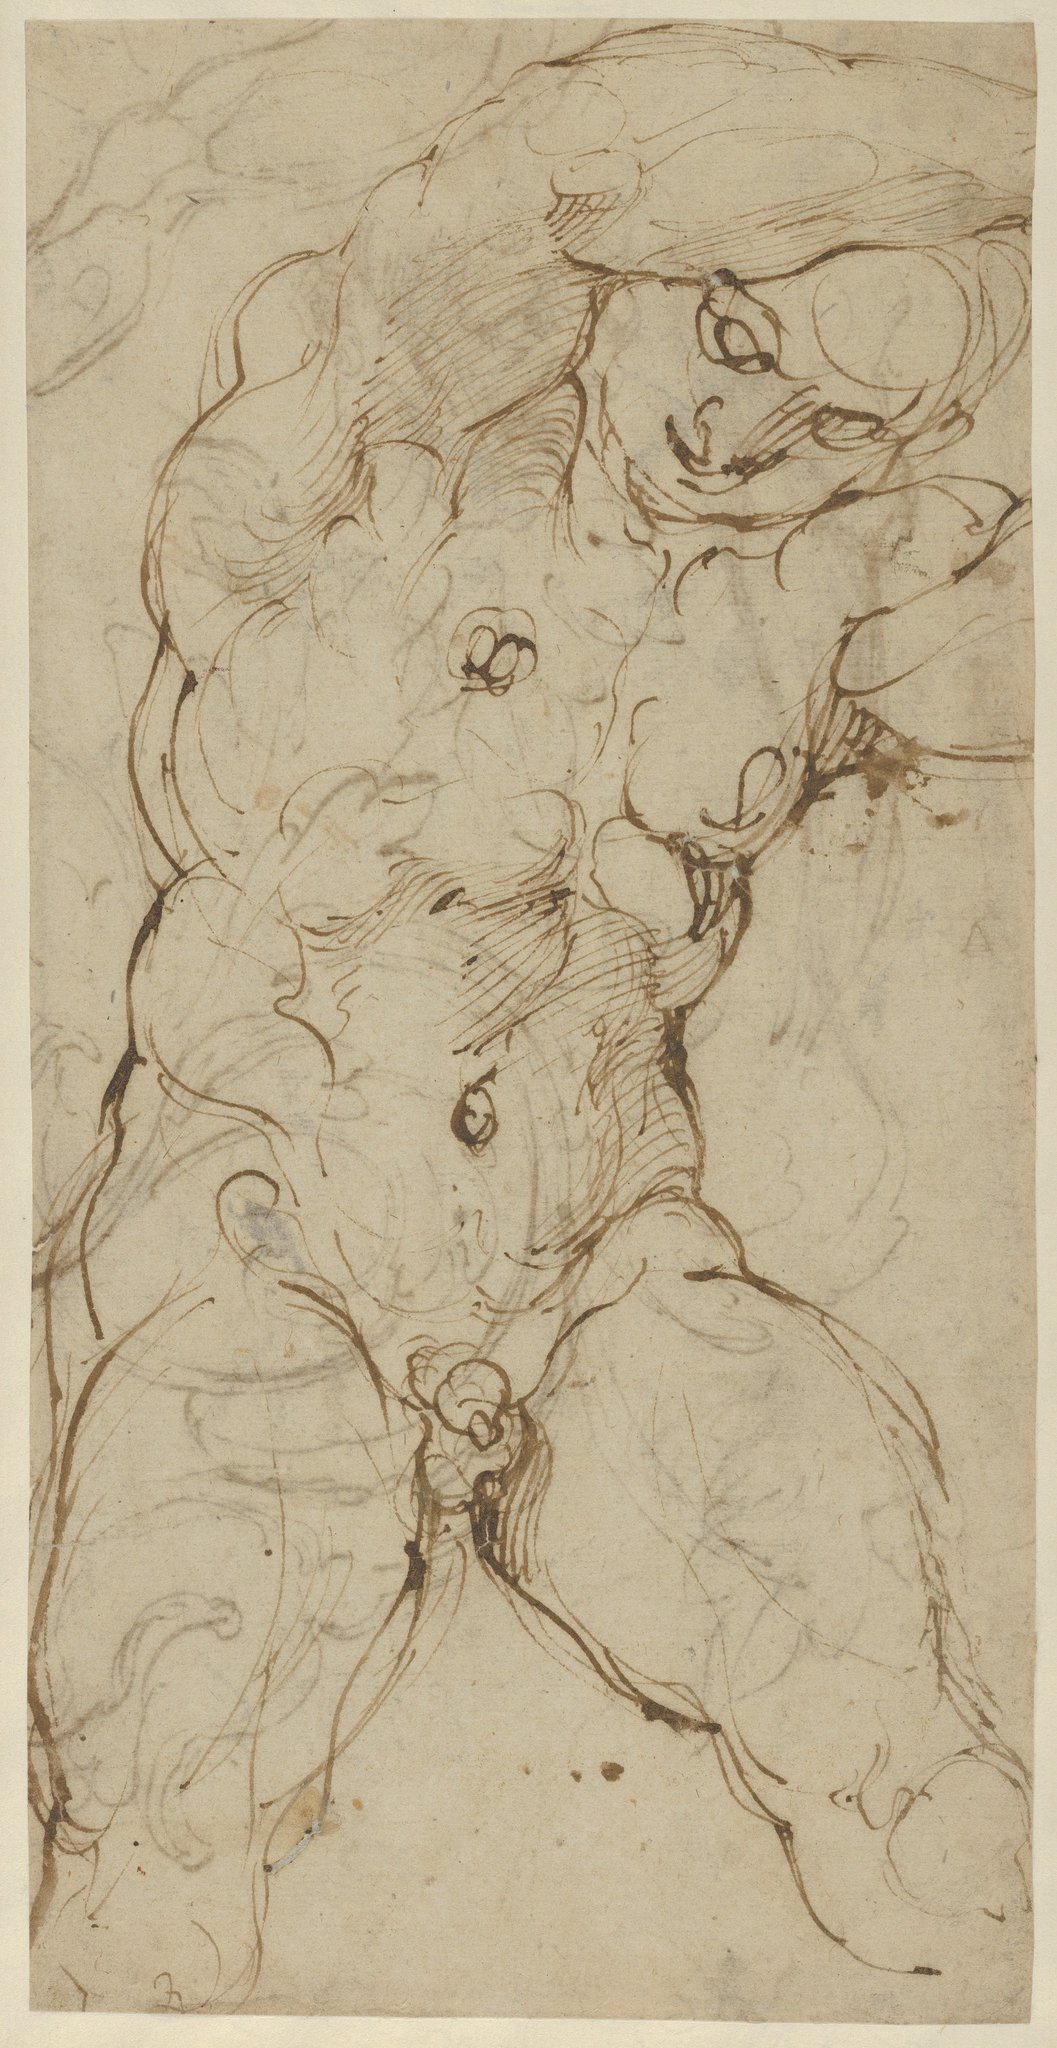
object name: drawing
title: Seated Nude Male Figure (recto); Ornamental Designs of Foliage, a Grotesque Head, and a Leg (verso)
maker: agostino carracci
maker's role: artist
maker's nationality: italian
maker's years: 1557-1602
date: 1590-1593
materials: chalk, ink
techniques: pen, drawing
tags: male nudes